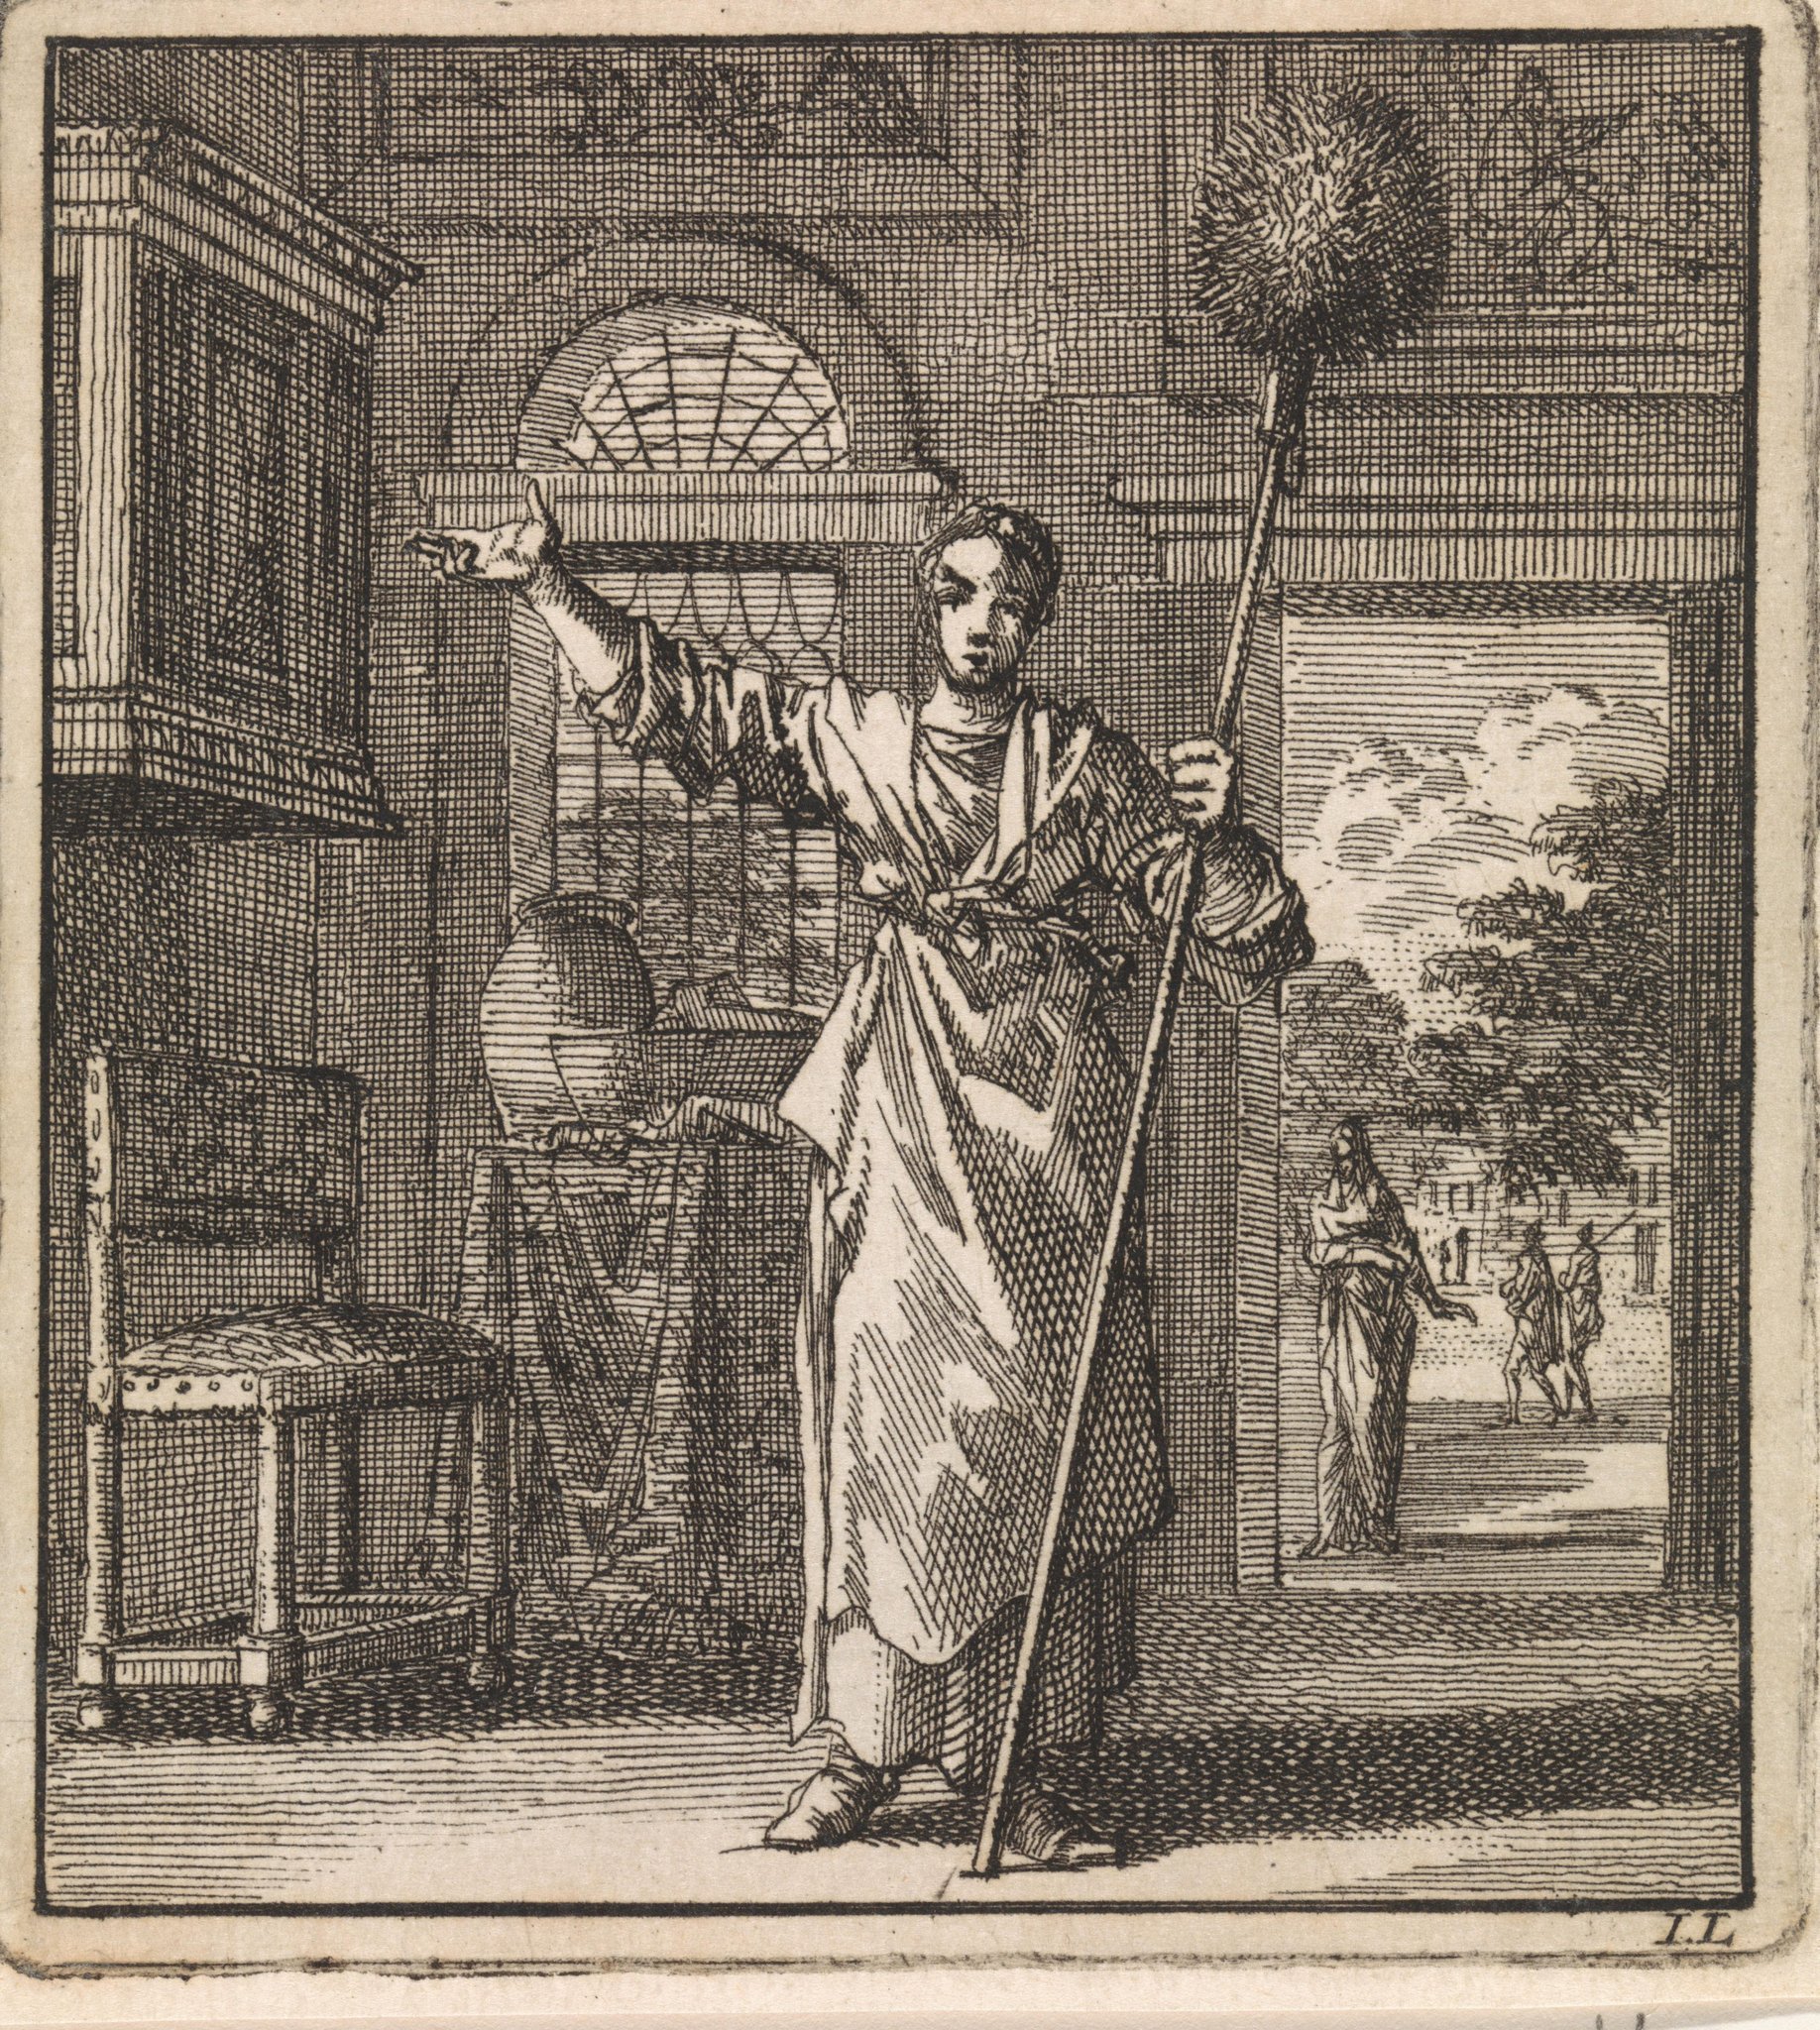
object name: book illustration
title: Vrouw met een ragebol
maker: jan luyken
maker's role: draughtsman, print maker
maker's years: 1649-1712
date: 1711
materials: paper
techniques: etching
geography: amsterdam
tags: picture, painting, cleaning (the house)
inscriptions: collector's mark: Lugt 2228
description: Illustratie voor: Luyken, Jan. Het leerzaam huisraad, vertoond in vyftig konstige figuuren, met godlyke spreuken en stichtelyke verzen: Pieter Arentsz. II (wed.) en Cornelis van der Sys, 1711, p. 78.